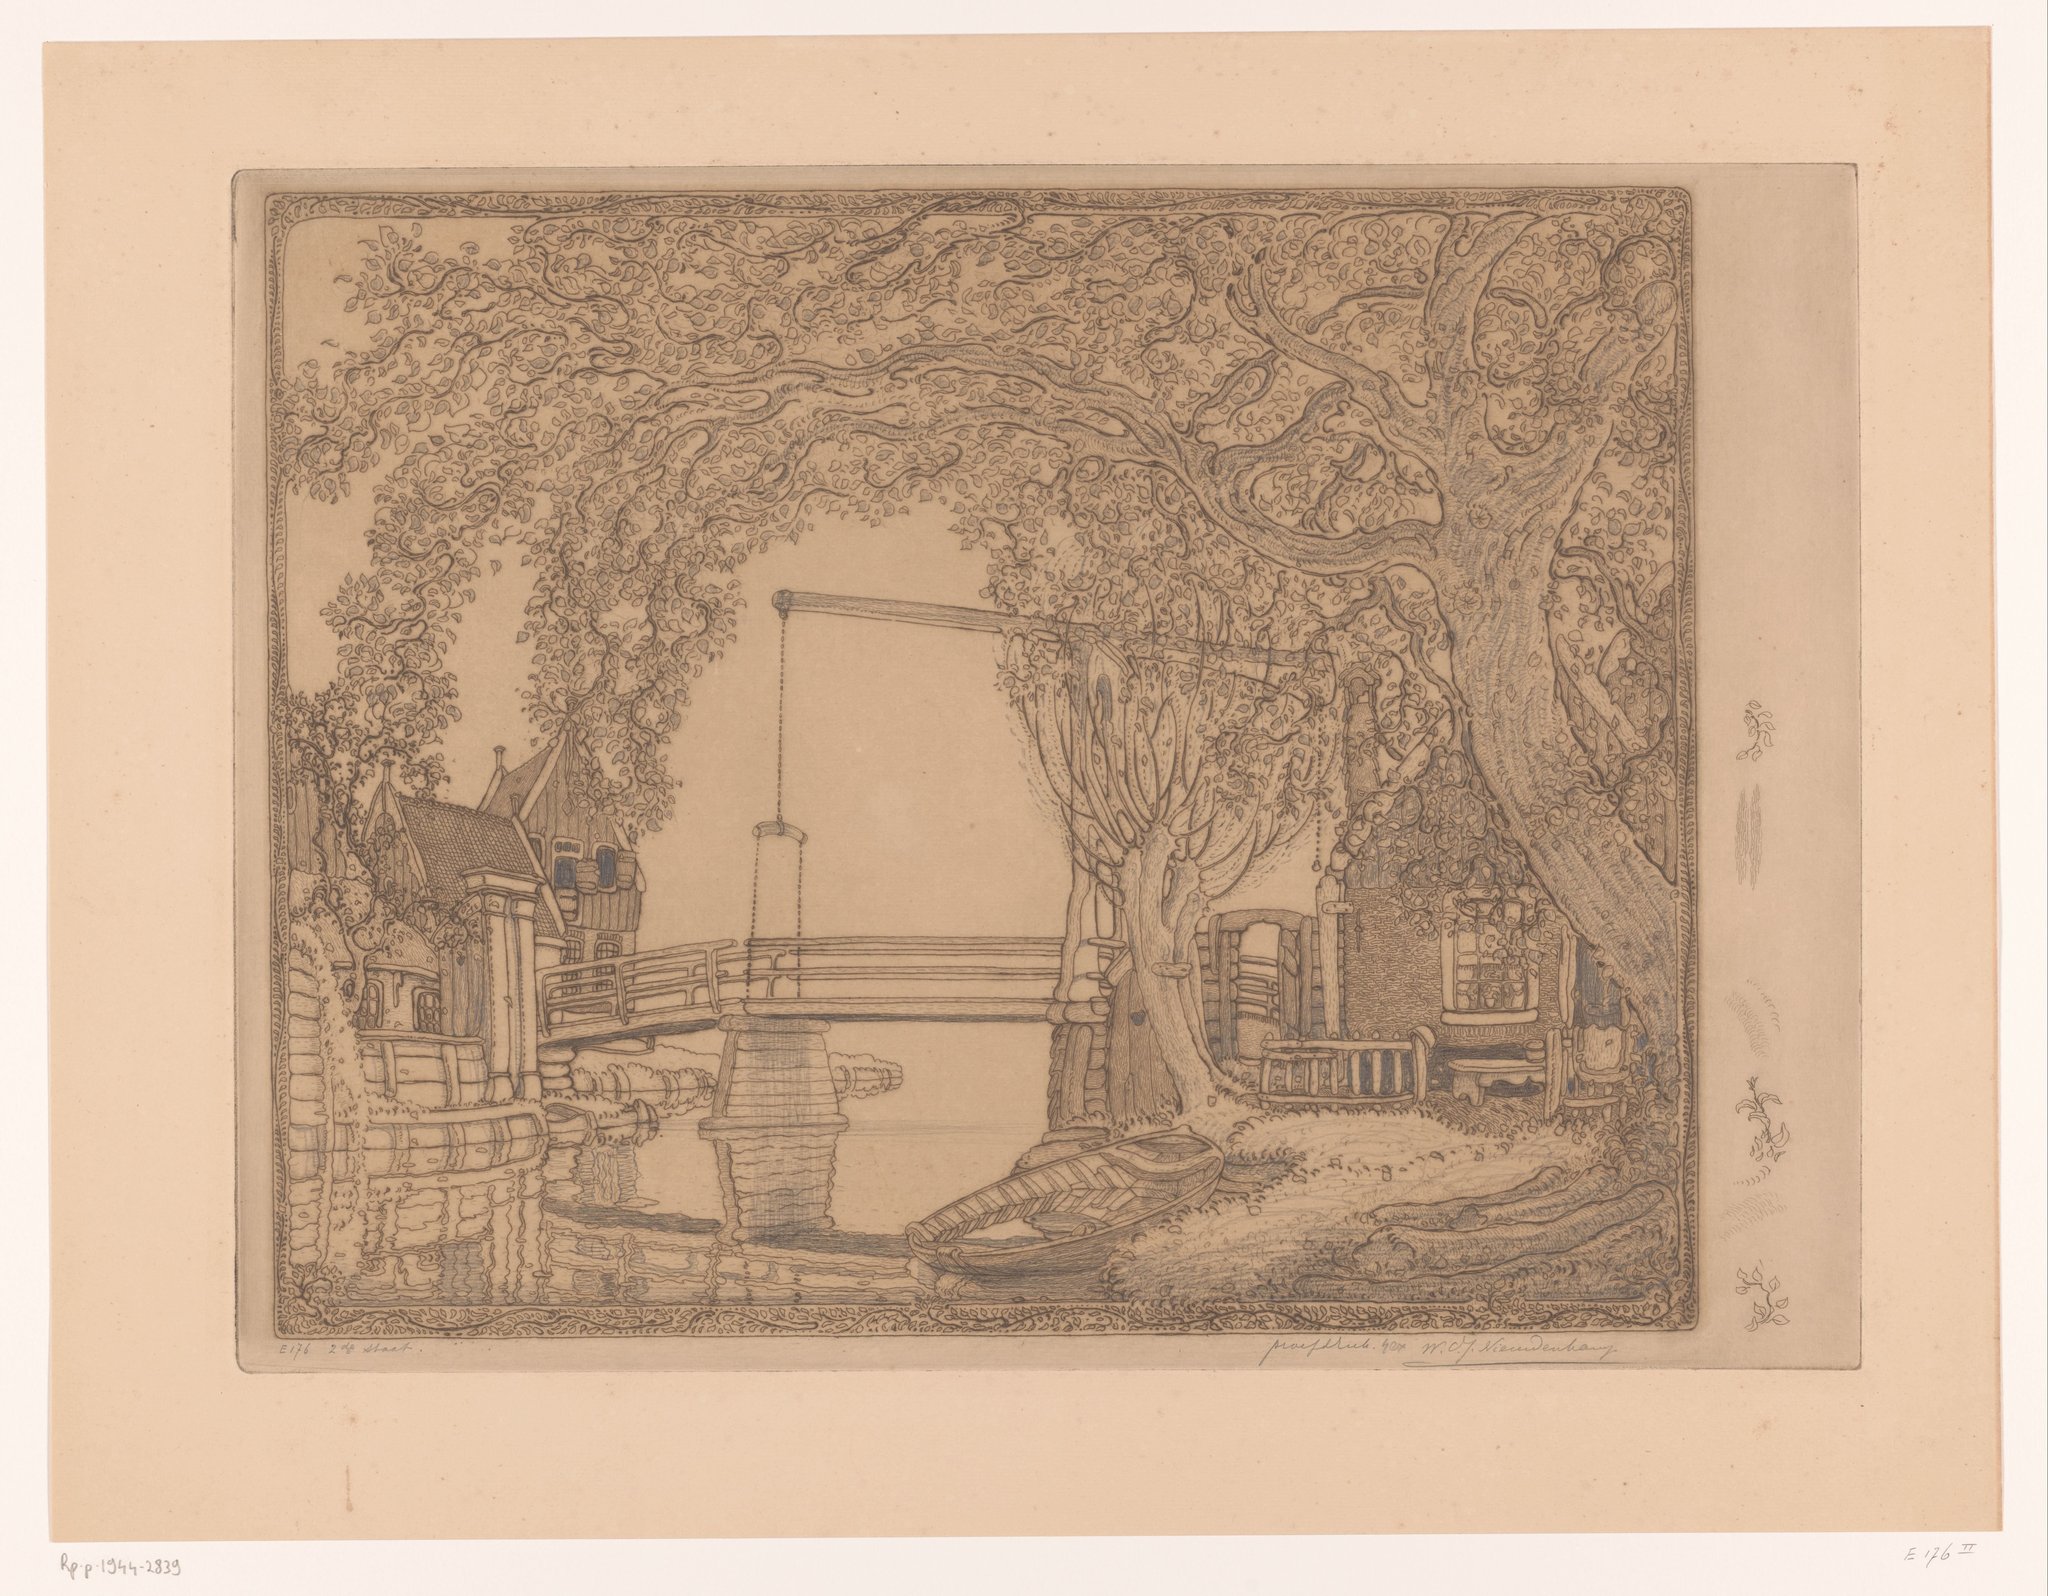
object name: print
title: De ophaalbrug Edam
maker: wijnand otto jan nieuwenkamp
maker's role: draughtsman, print maker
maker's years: 1874-1950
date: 1903-1916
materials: paper, pencil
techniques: etching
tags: village, bridge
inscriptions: collector's mark: Lugt 2228